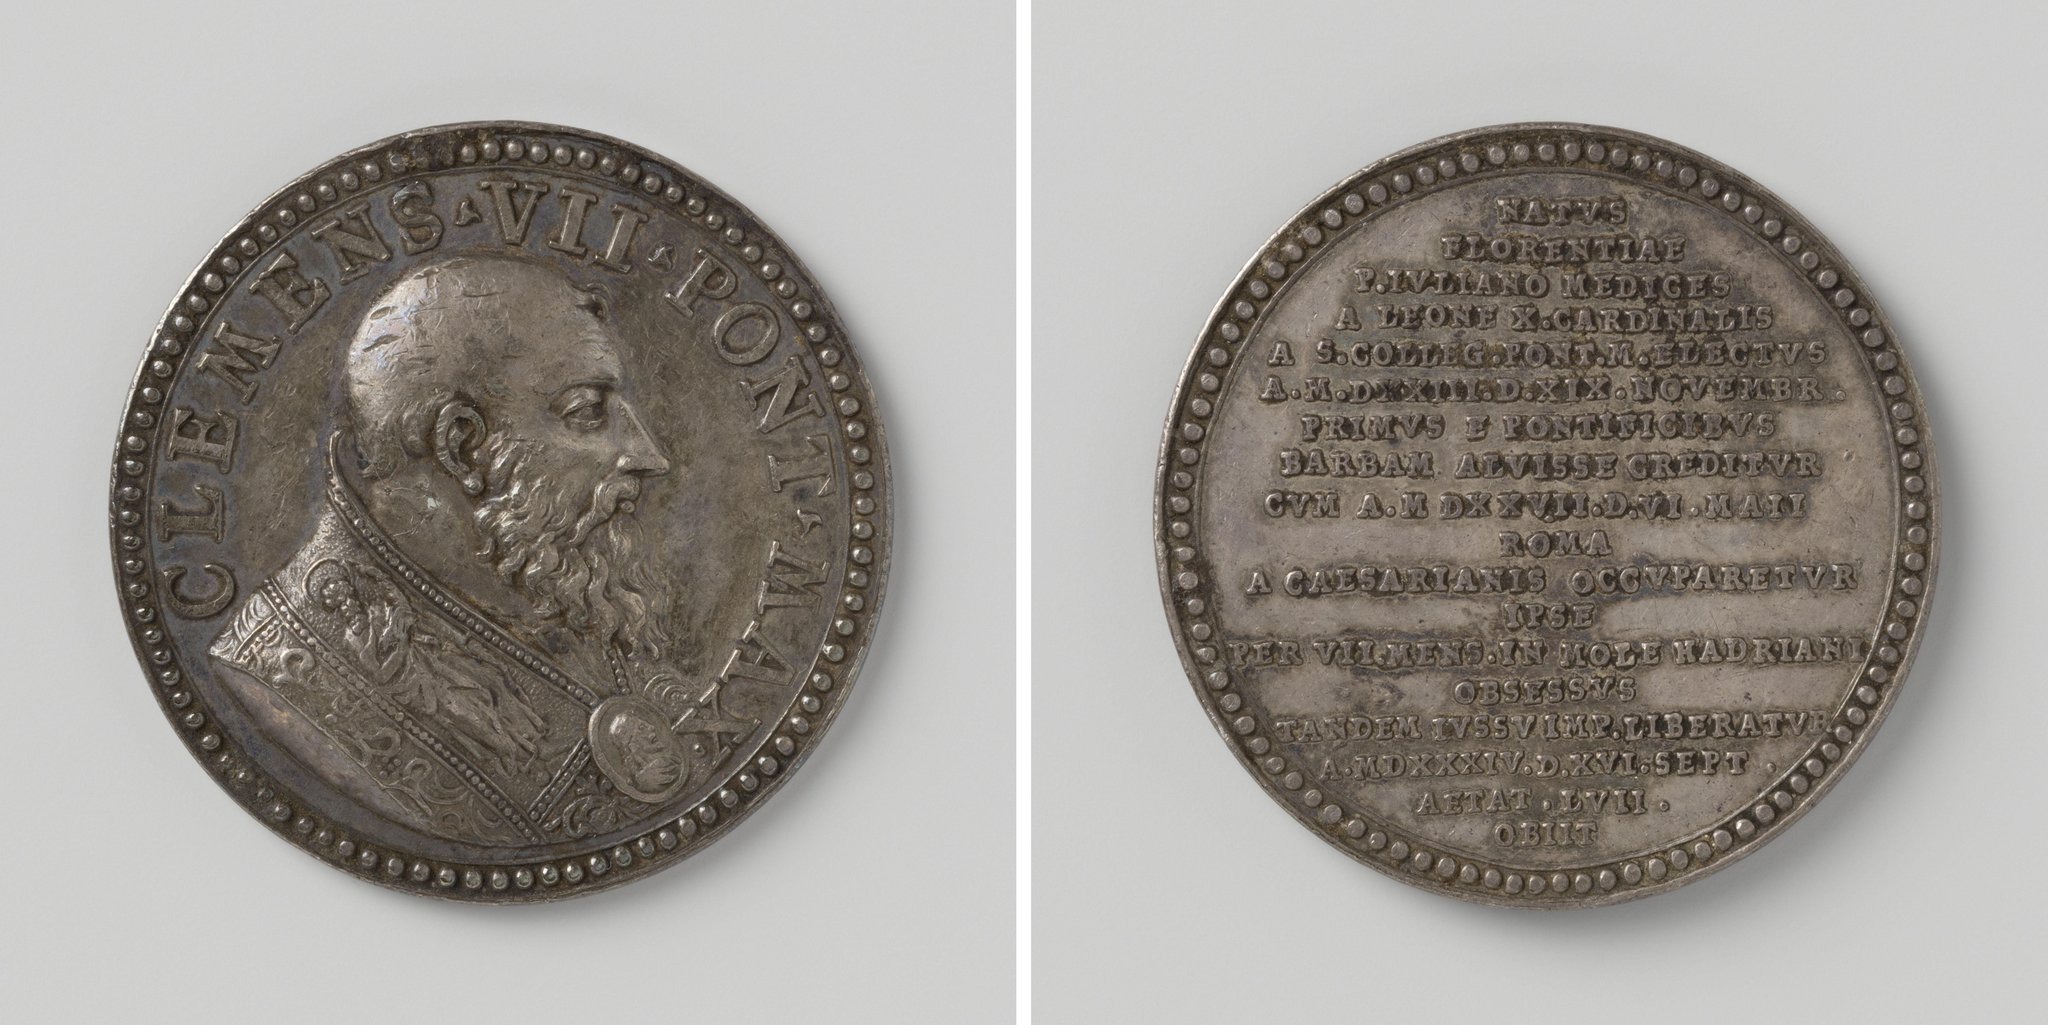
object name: history medal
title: Overlijden van Clemens VII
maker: Anonymous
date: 1534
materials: silver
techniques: striking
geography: italy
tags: rome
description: Zilveren penning. Voorzijde: borststuk man binnen omschrift. Keerzijde: opschrift